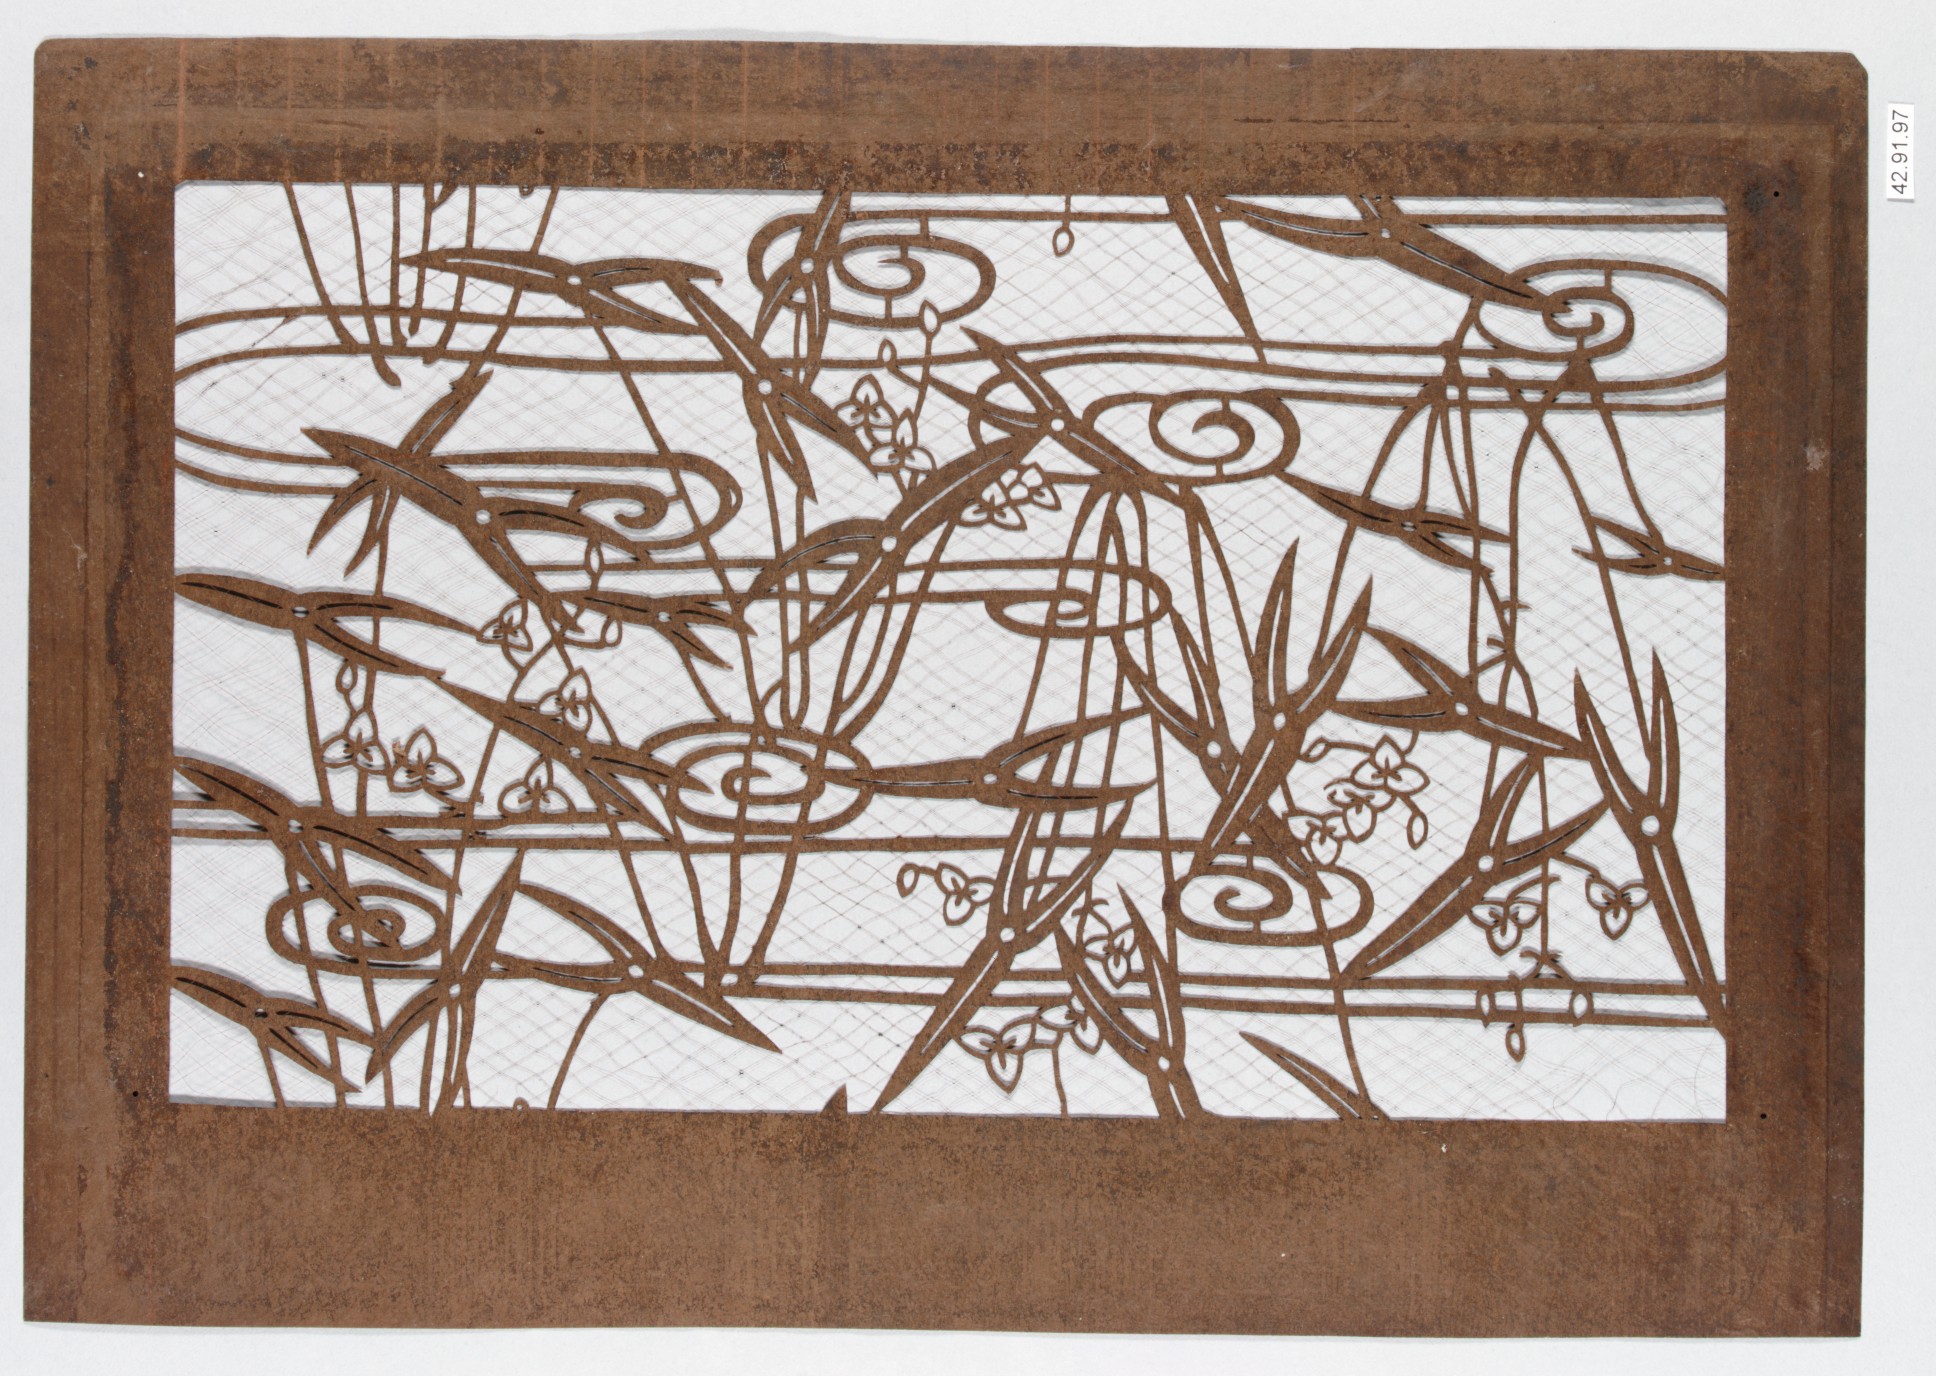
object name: stencil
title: Stencil with Pattern of Water Plants (Omodaka)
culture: japanese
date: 1801-1900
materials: paper, silk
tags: plants